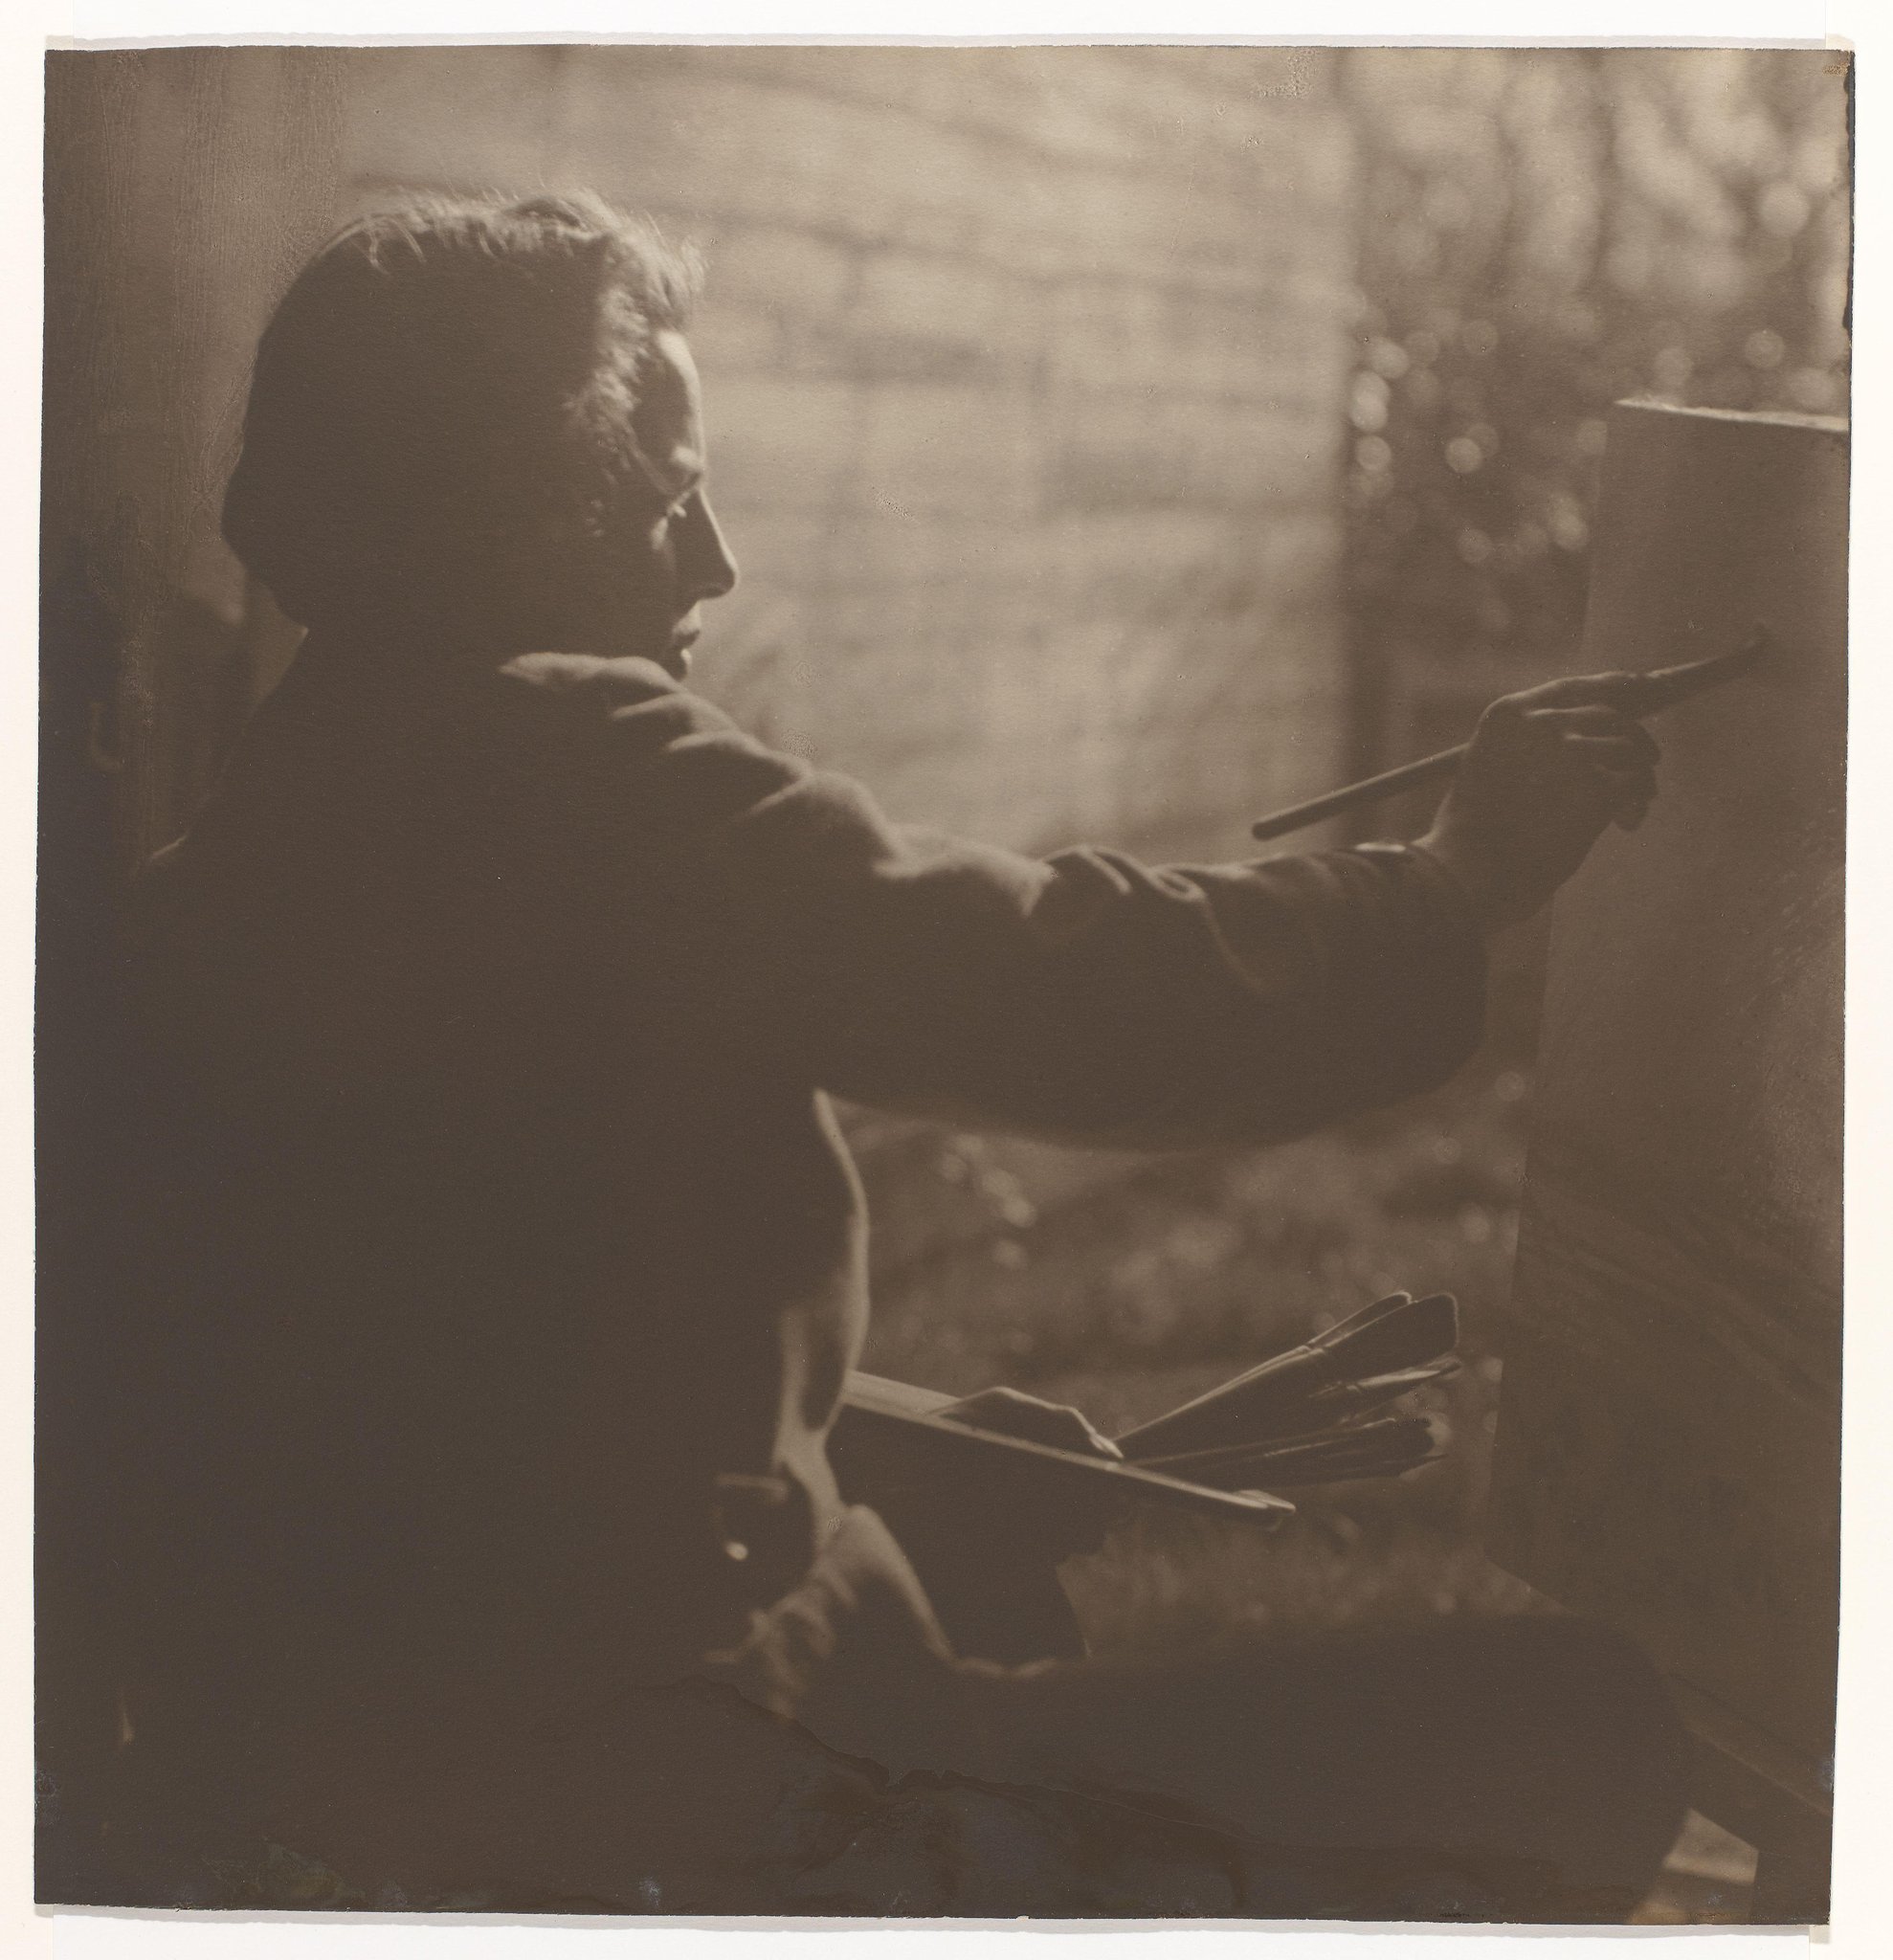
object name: photograph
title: Portret van de kunstenaar Wim Schuhmacher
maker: jacques de boer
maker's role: fotograaf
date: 1920-1925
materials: photographic support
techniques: gelatin silver print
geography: den helder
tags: amsterdam, print maker, draughtsman, wim schuhmacher